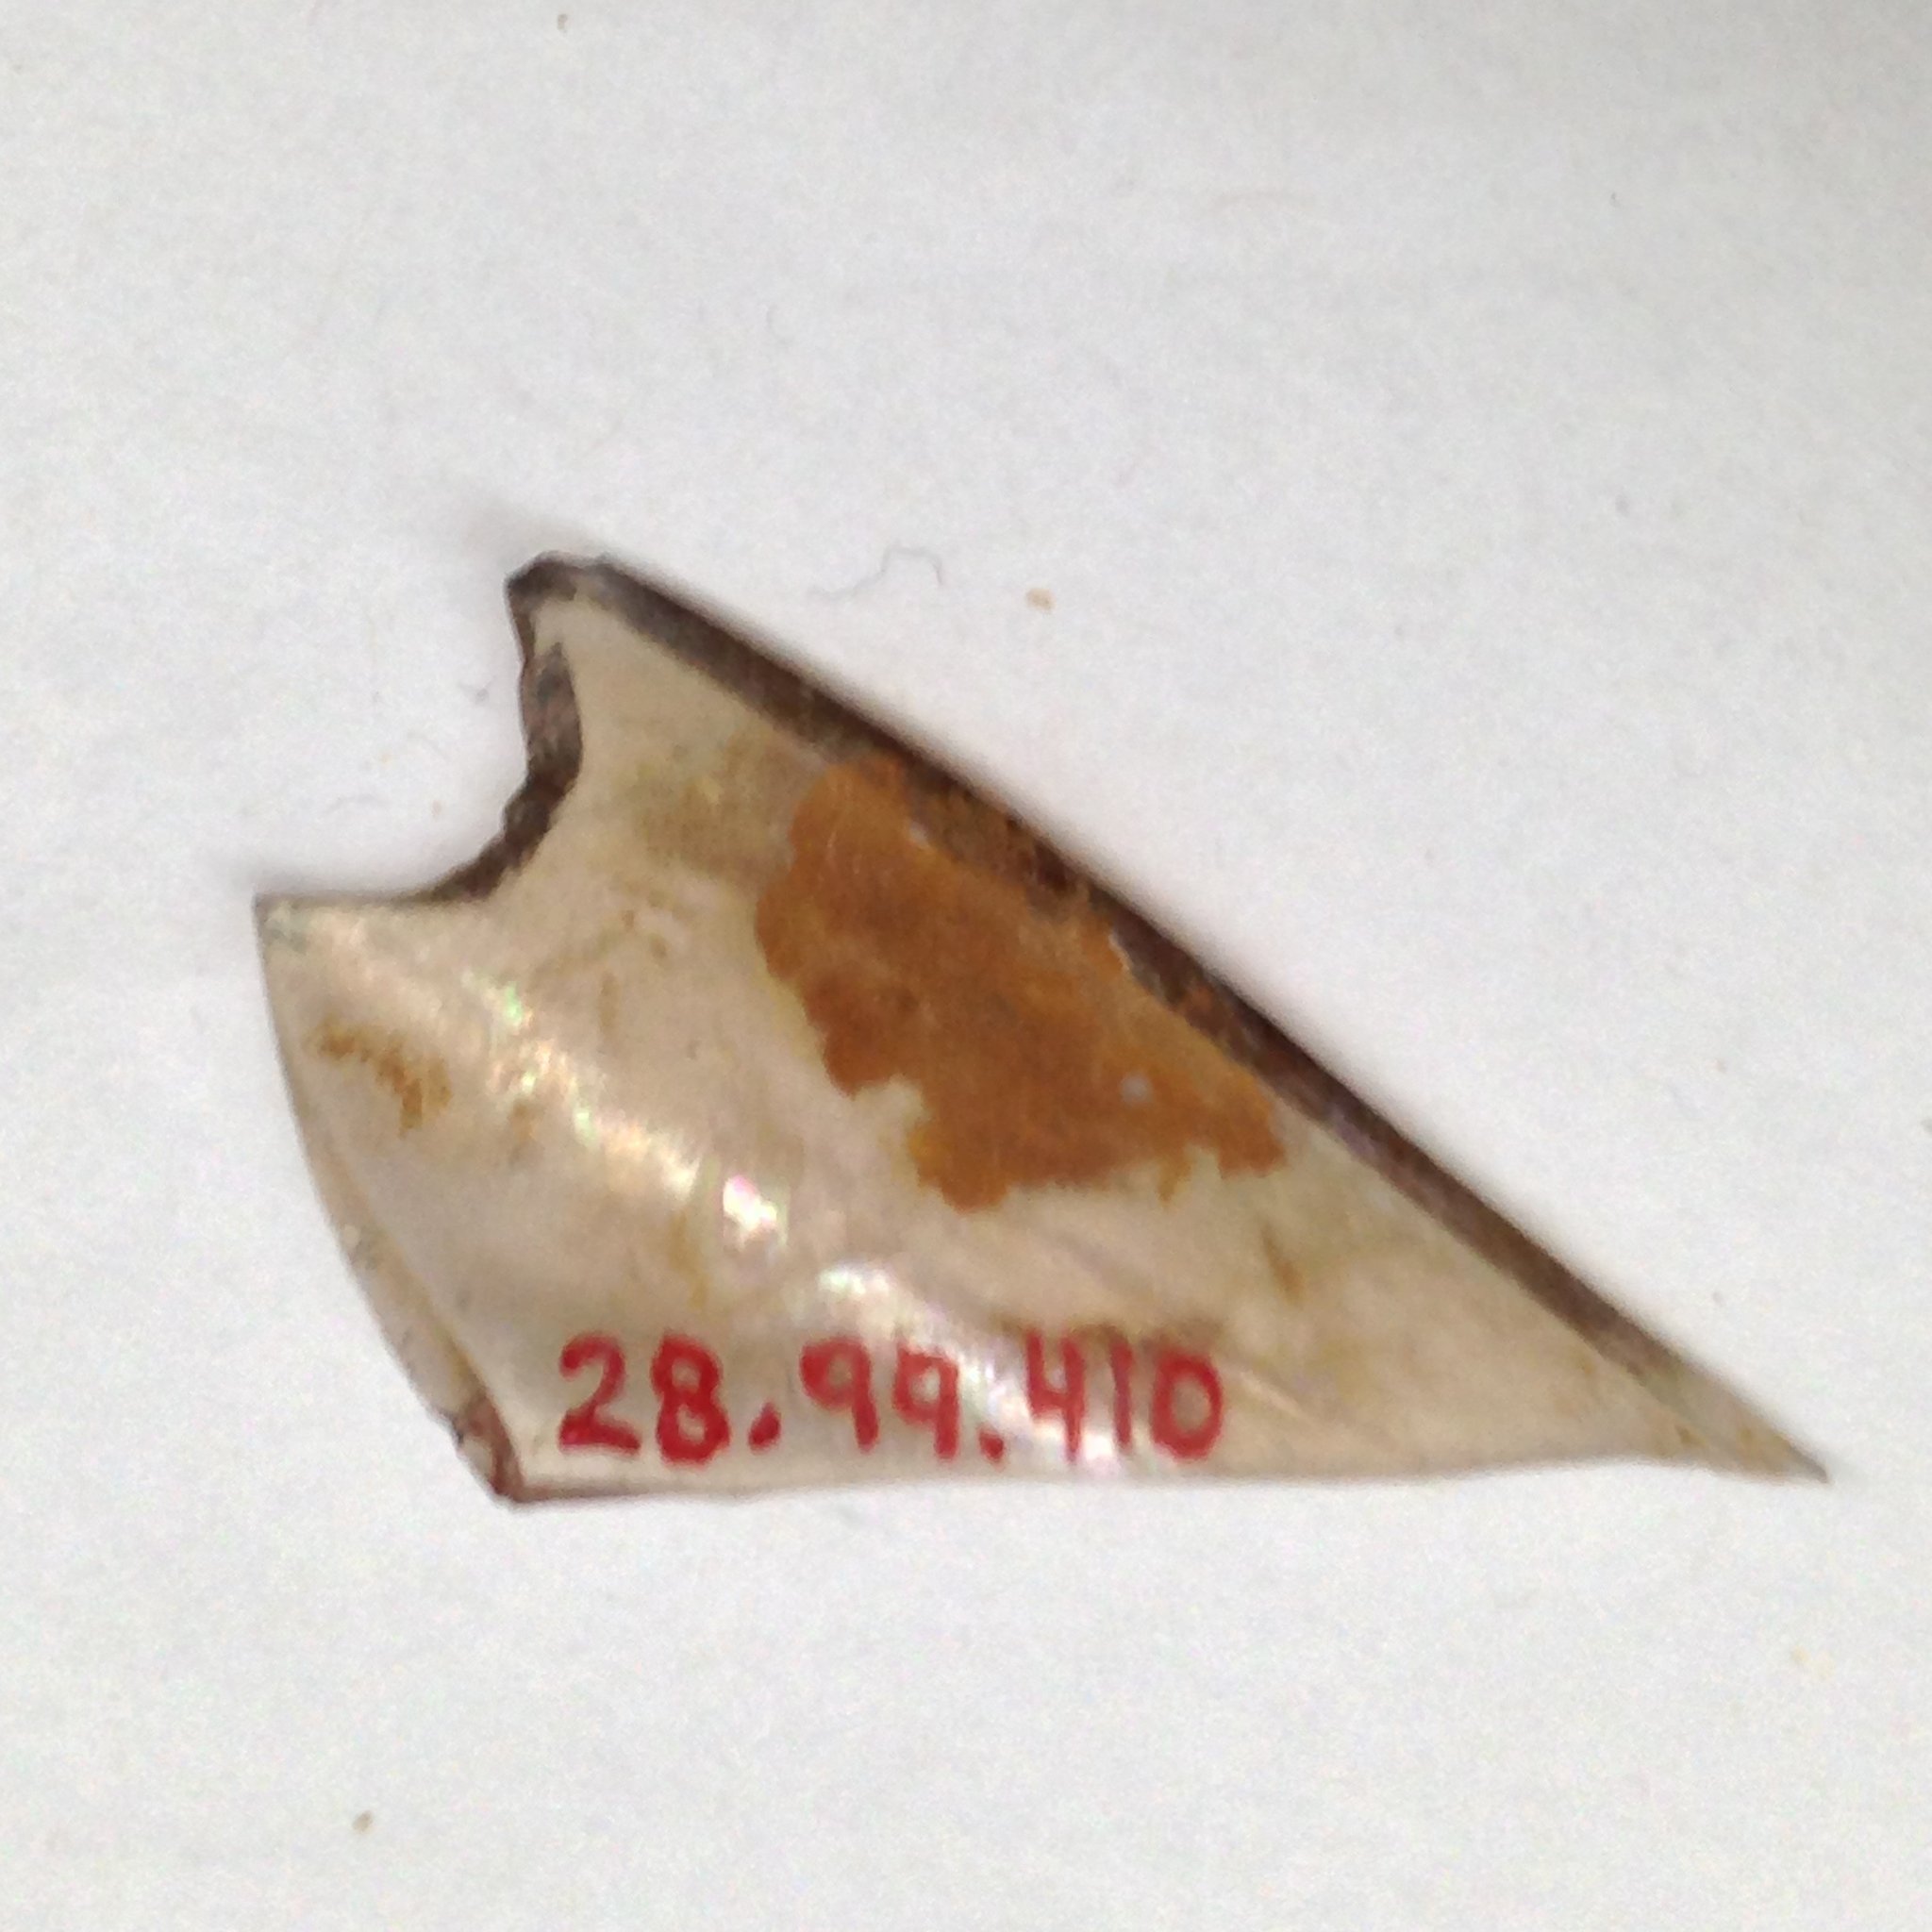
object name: fragment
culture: european or middle eastern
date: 1150-1250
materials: ceramic, glass